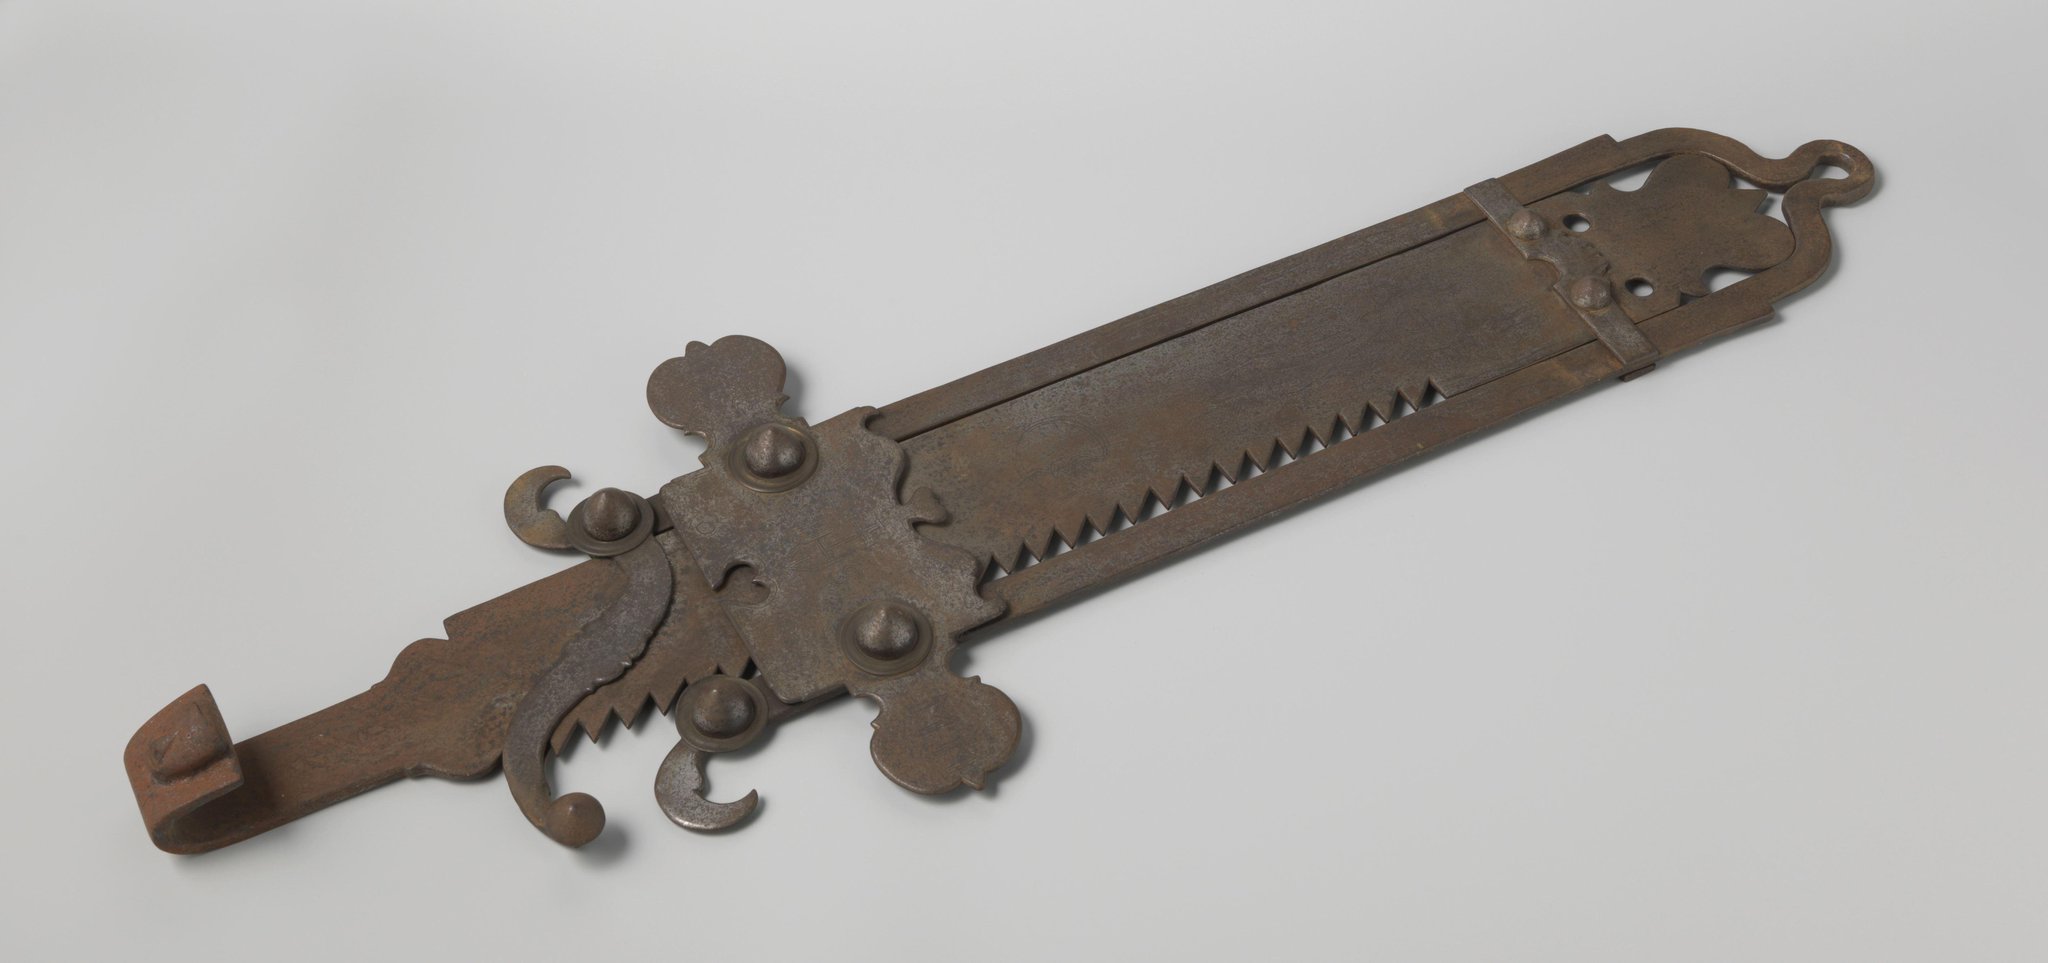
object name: chimney hook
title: Schoorsteen- of vuurhaak met ingegraveerde zon, maan en ster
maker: Anonymous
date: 1680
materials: copper, iron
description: Een ijzeren vuurhaak met ingegraveerde zon, maan en ster. Gemerkt en gedateerd met jaartal 1680.